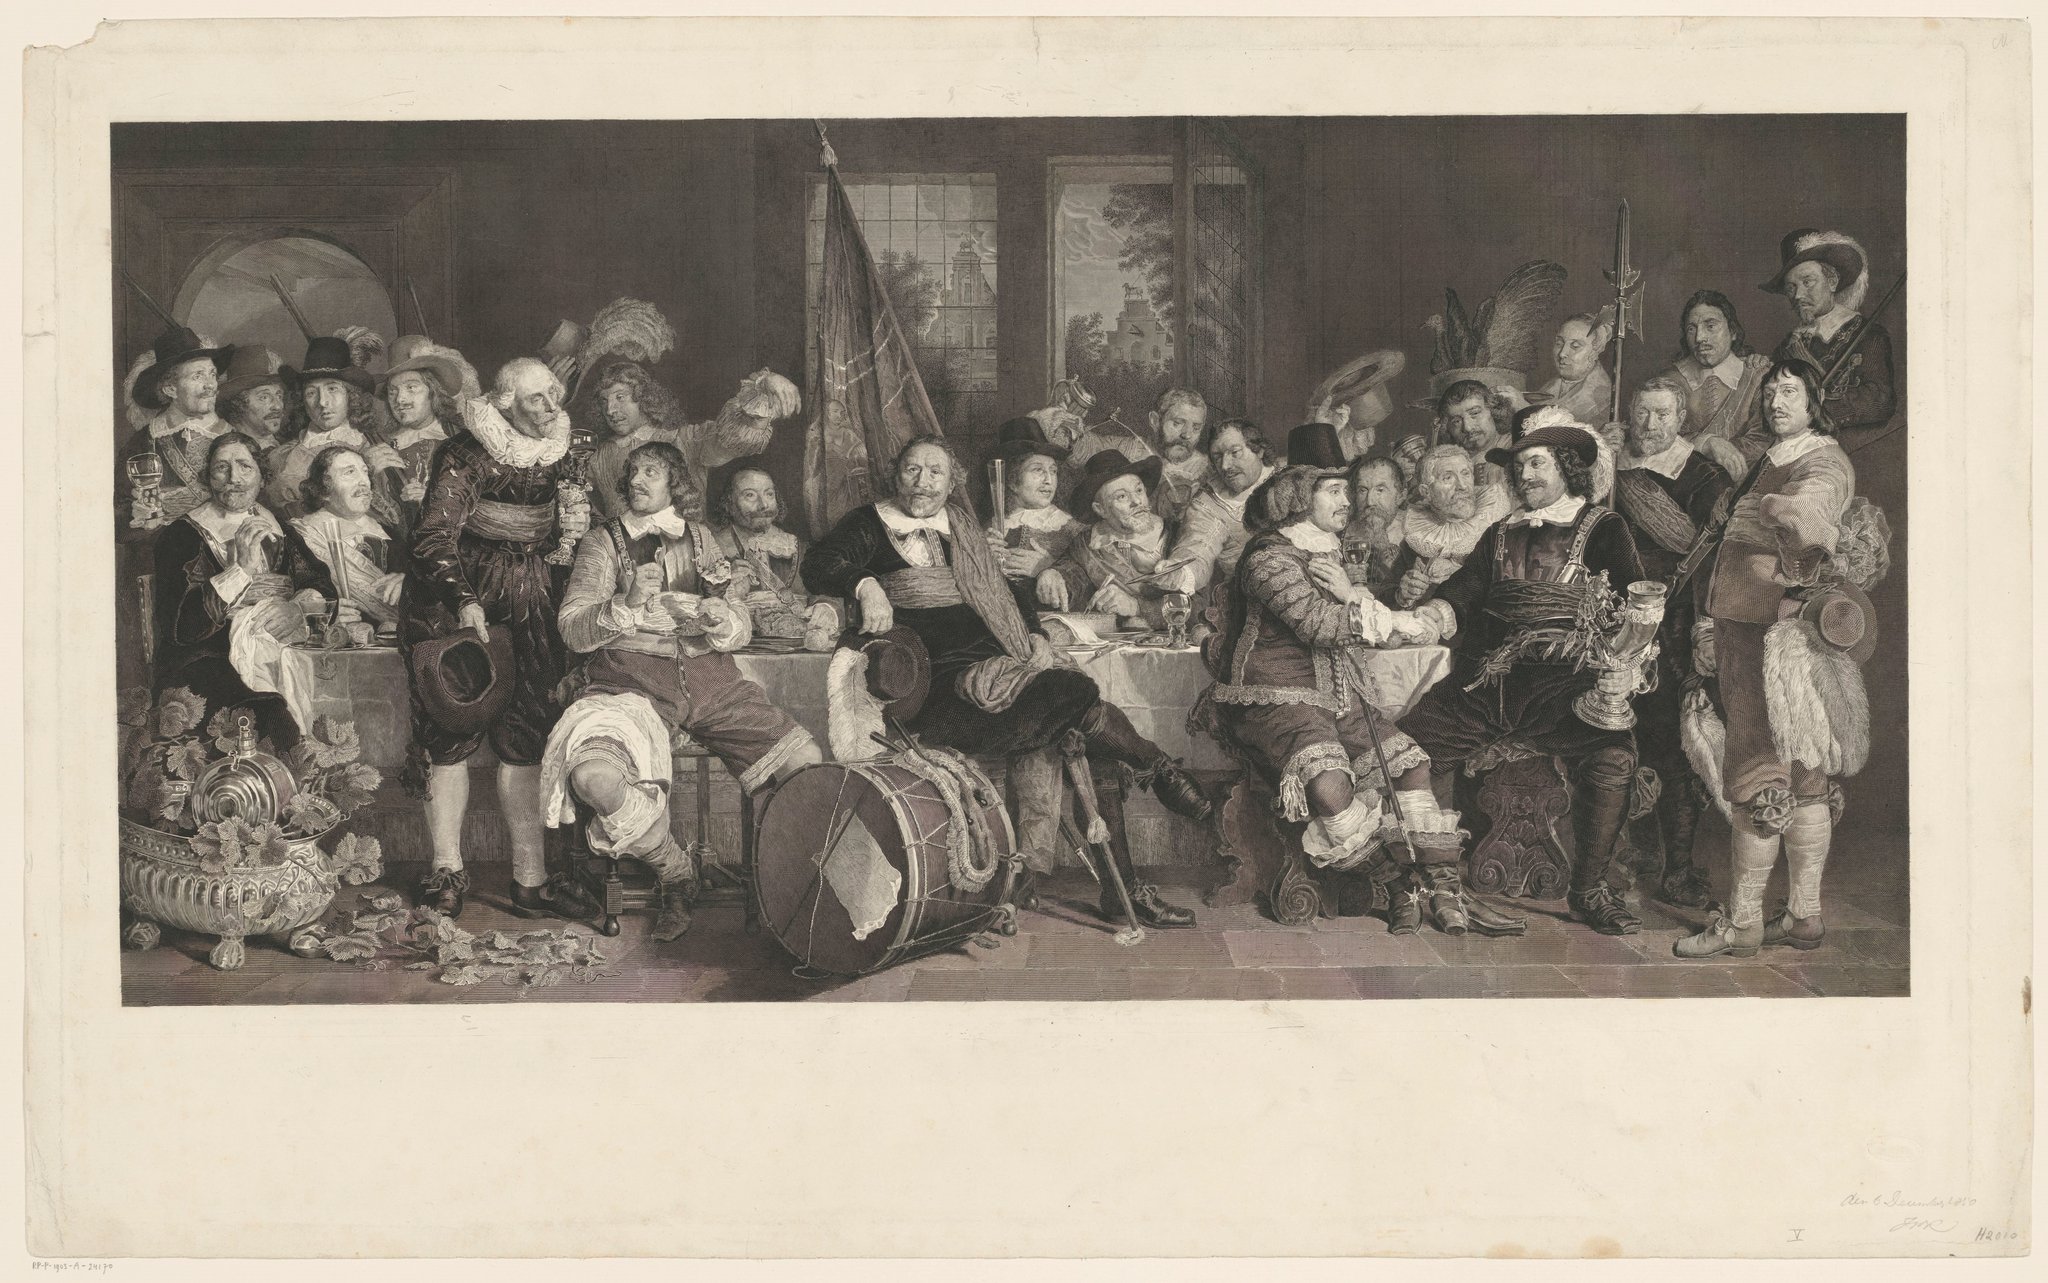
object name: print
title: De schuttersmaaltijd in de Voetboog- of St. Jorisdoelen te Amsterdam ter viering van het sluiten van de vrede van Munster, 18 juni 1648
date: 1850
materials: paper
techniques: engraving, etching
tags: cornelis witsen, warfare; military affairs (+ citizen soldiery, civil guard, citizen militia), glass, rummer, celebration meal, feast, banquet, (military) flags and standards, private festivities, merry company, amsterdam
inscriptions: collector's mark: Lugt 2228, check stamp: ‘François Buffa & Fils/ Amsterdam’